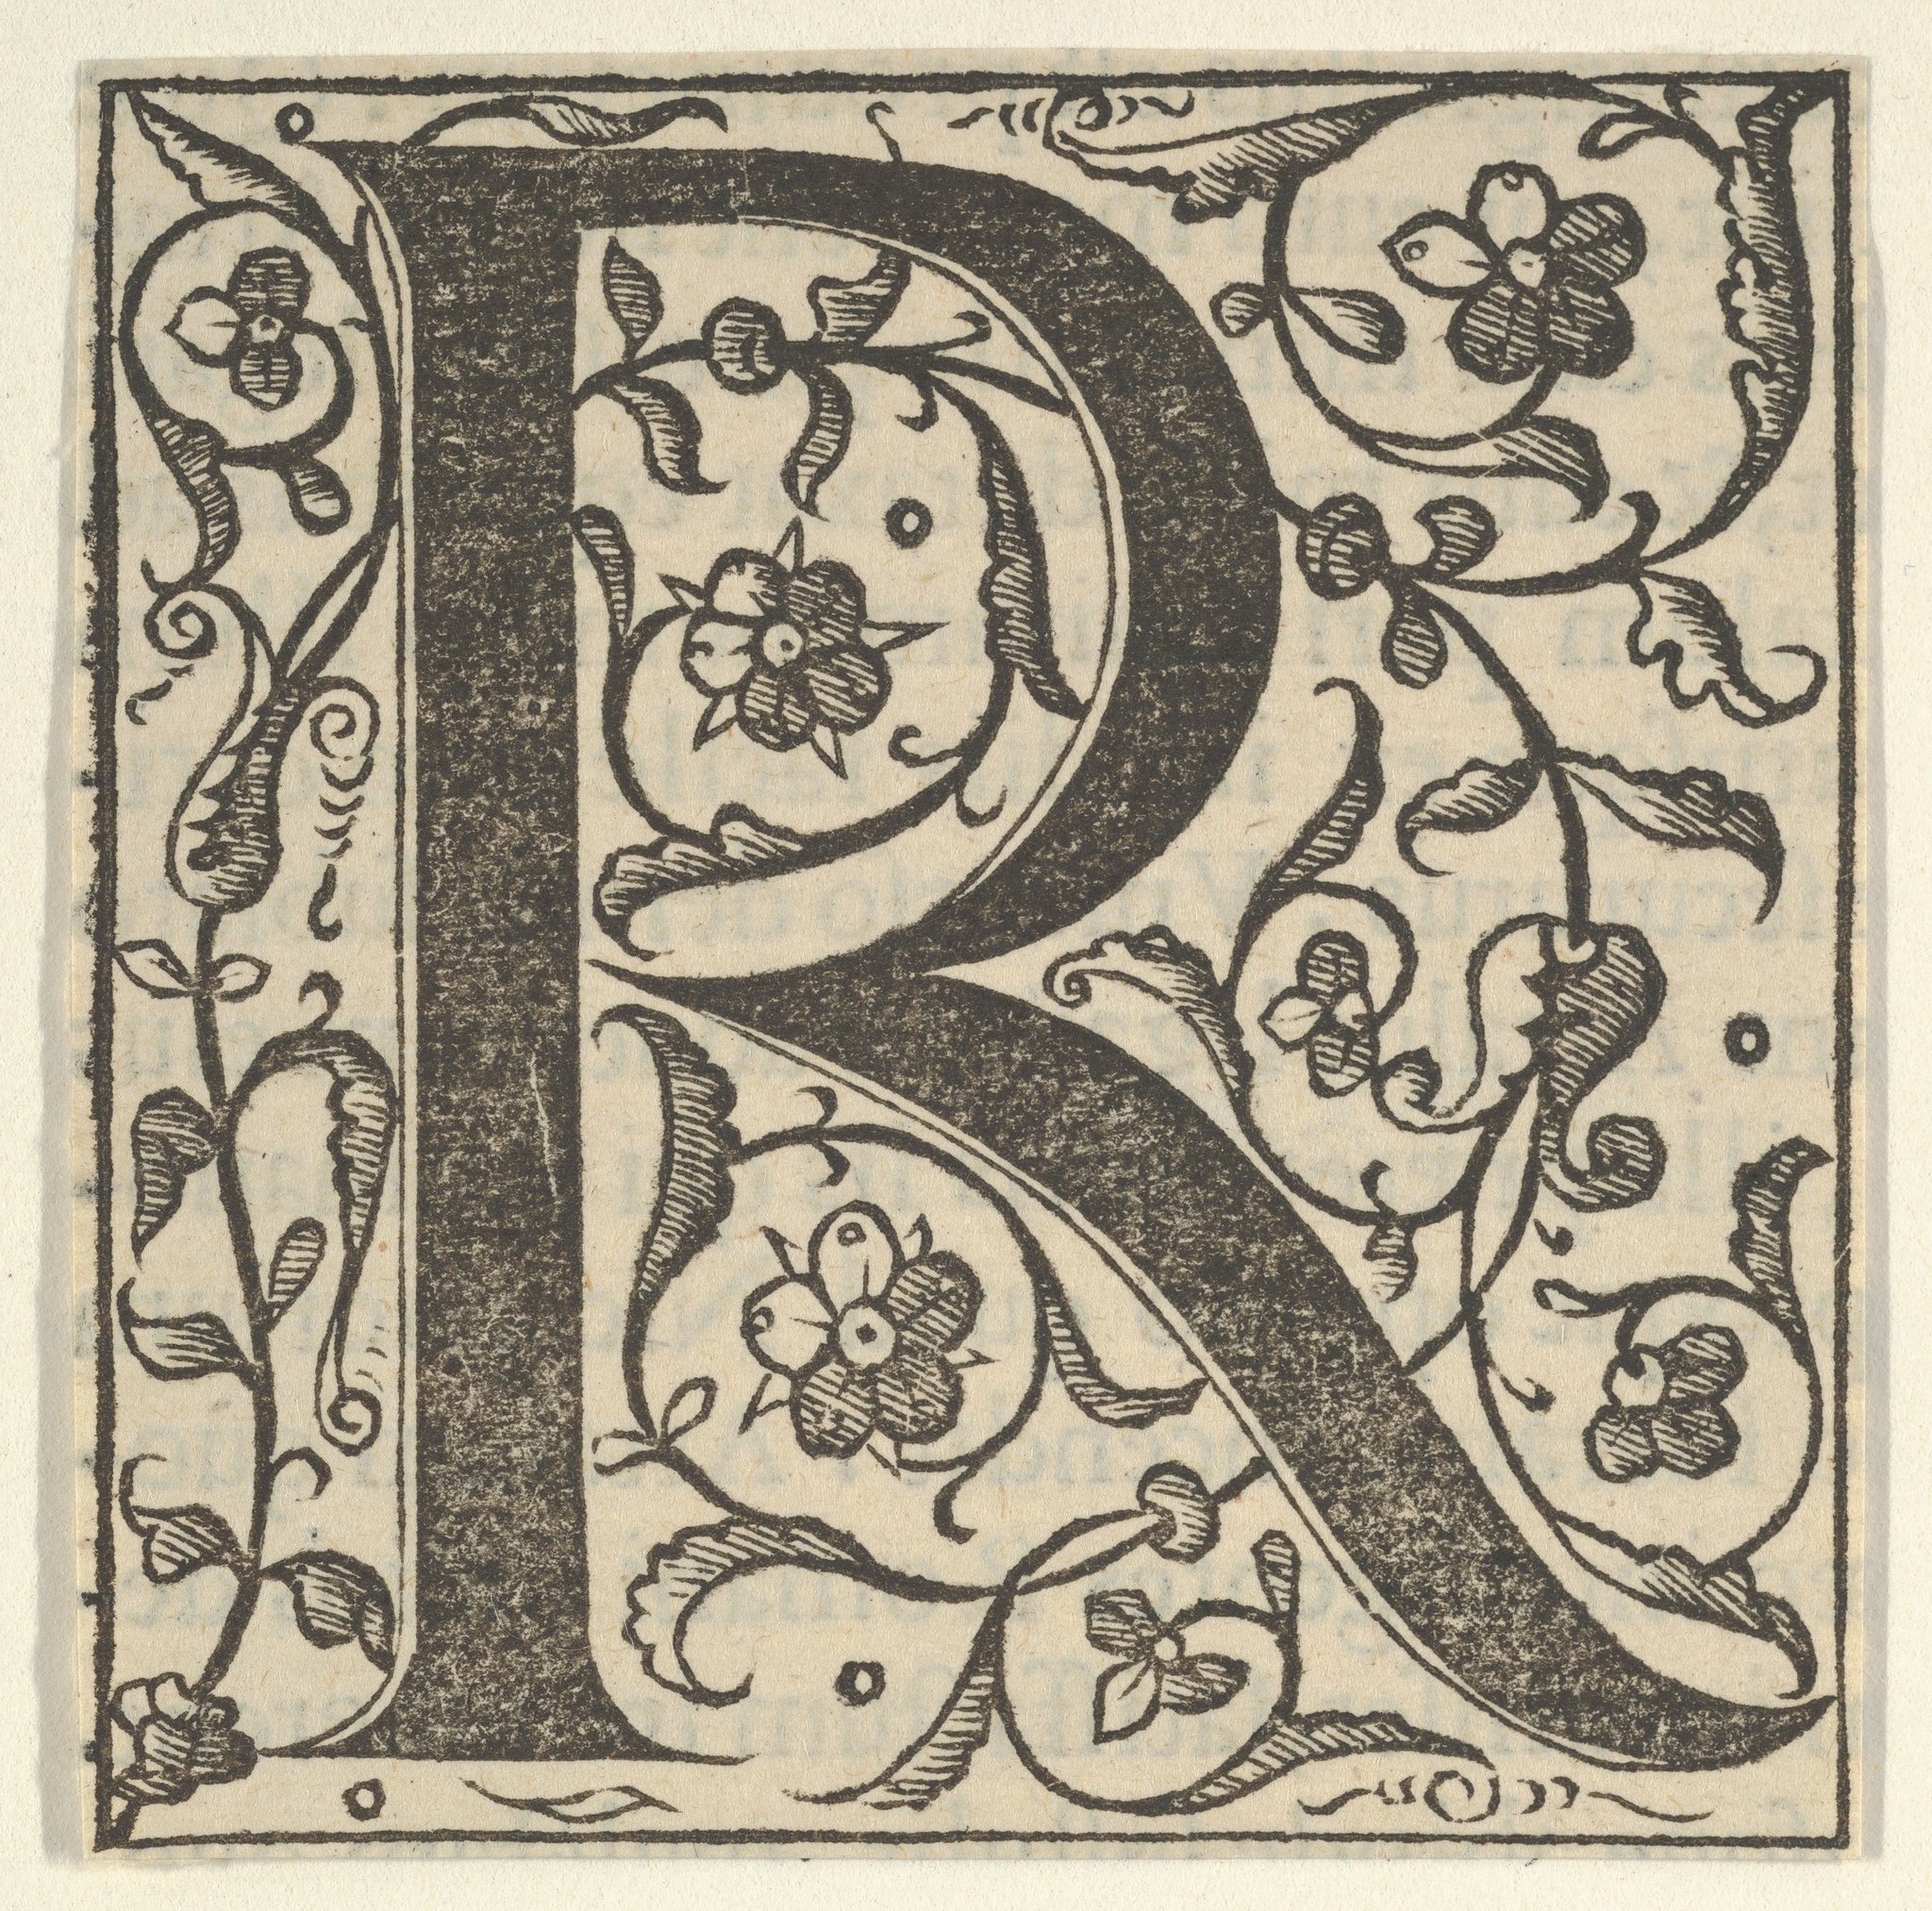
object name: print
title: Initial letter R with garlands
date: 1534-1566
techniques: woodcut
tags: garlands